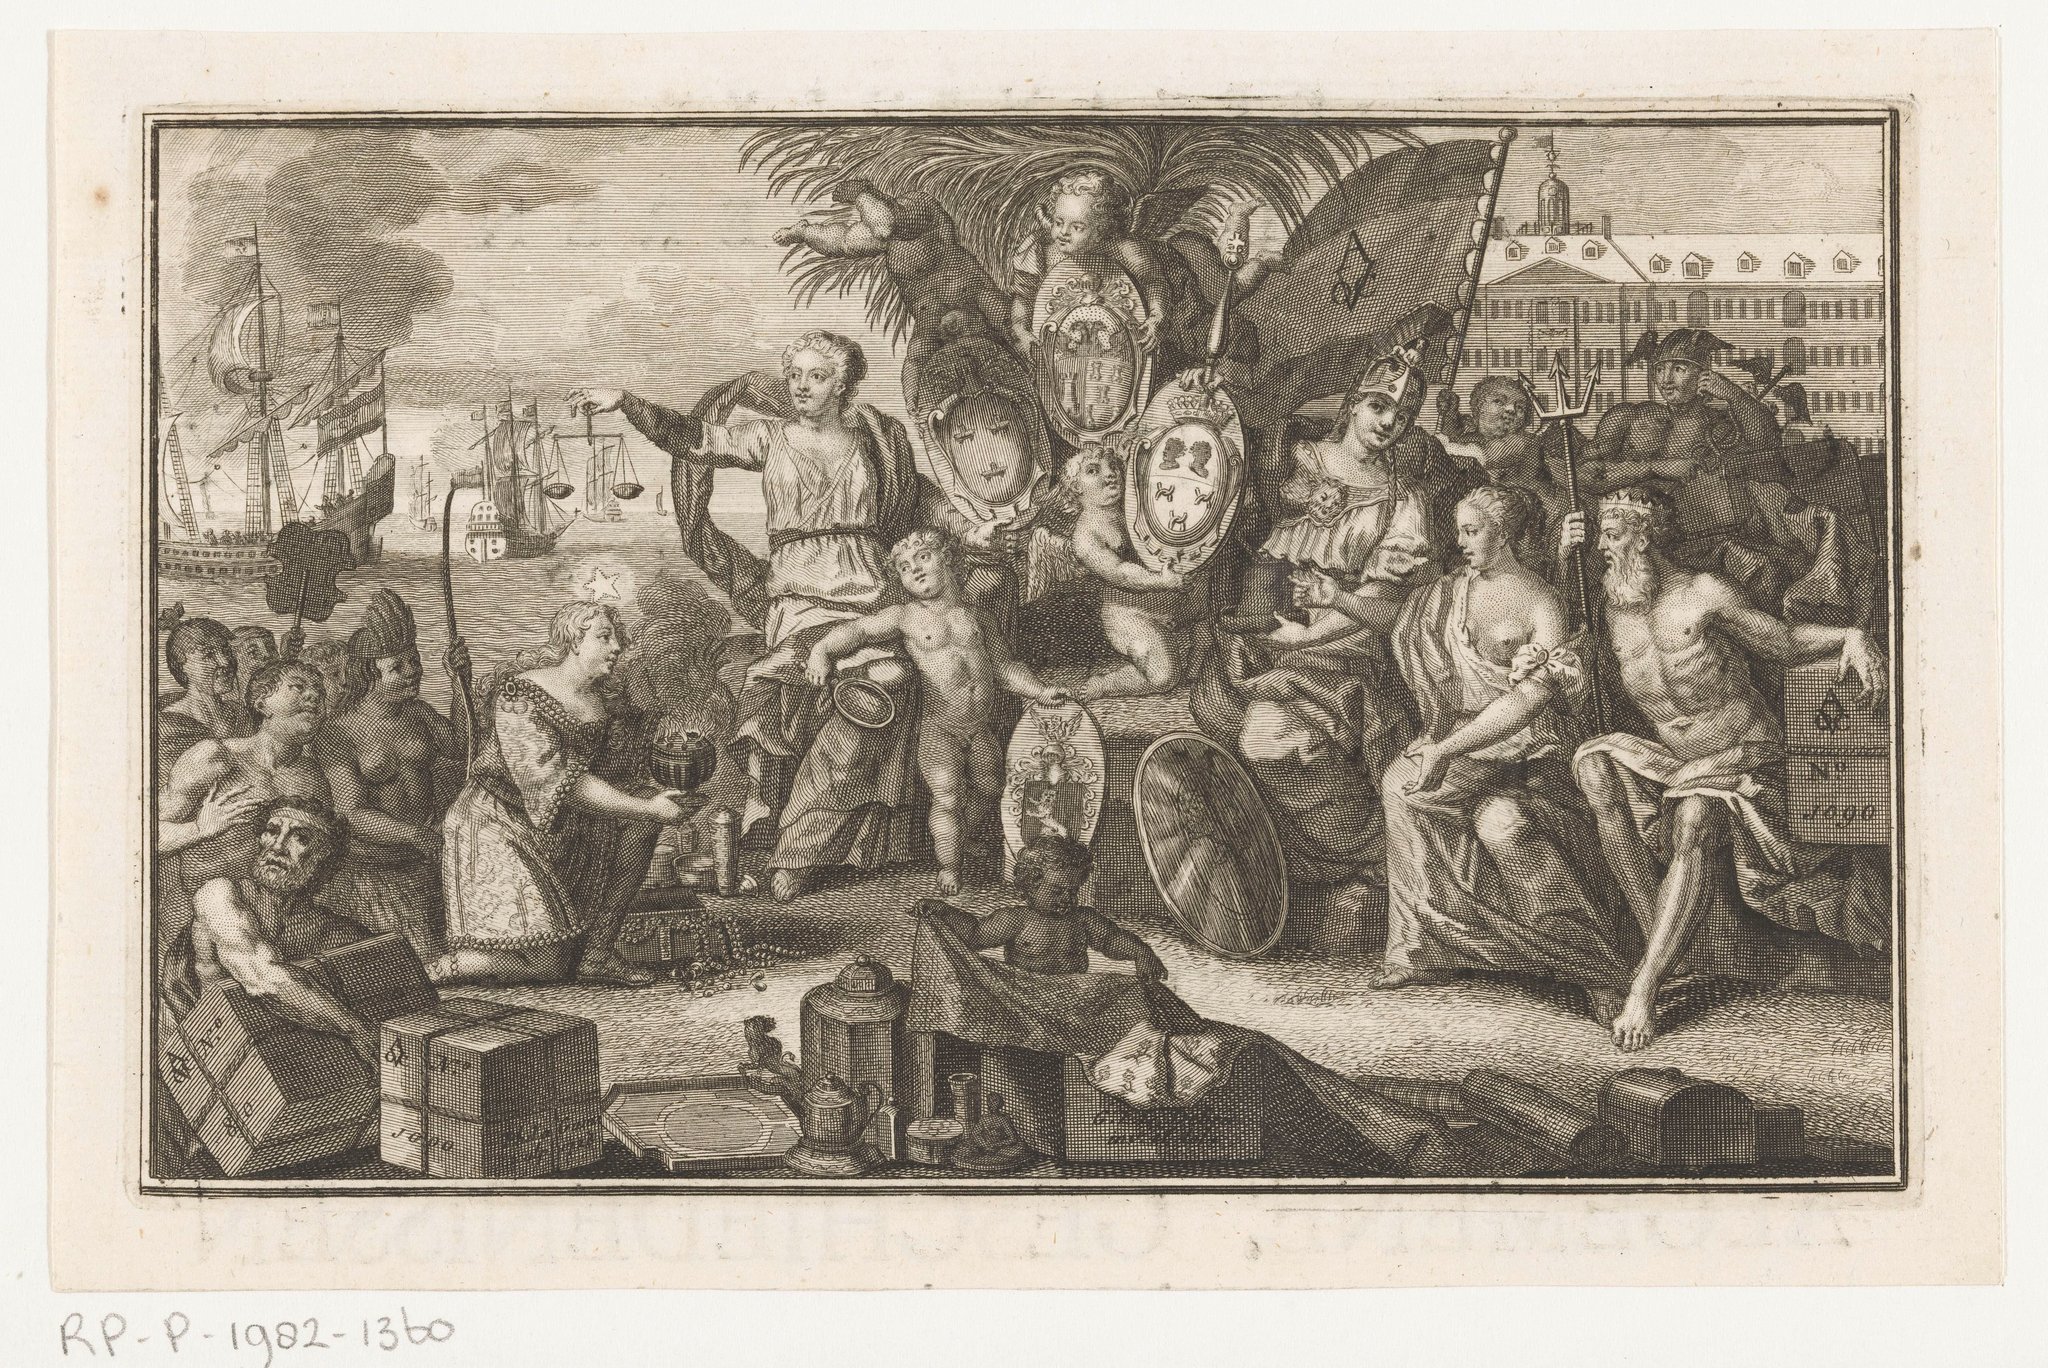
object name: print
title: Allegorie op de Oost-Indische Compagnie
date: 1728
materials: paper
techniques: etching, letterpress printing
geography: amsterdam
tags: asiatic races and peoples, trade-company, justice, 'justitia'; 'giustitia divina' (ripa) ~ one of the four cardinal virtues, (story of) minerva (pallas, athena)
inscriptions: collector's mark: Lugt 2760, collector's mark: Lugt 2228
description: Putti met wapenschilden van Aegidius van den Bempden, Hendrik Trip, Adriaan van Loon en Reinier Bouwens (burgemeester en bewindhebbers van de handelscompagnie) worden geflankeerd door Rechtvaardigheid met weegschaal en Minerva met (vrijheids)hoed in de hand. Rechts een putto met vlag van de VOC, Mercurius als handelsgod, Neptunus als god van de zee, een allegorische vrouwenfiguur en het Oostindisch-magazijn te Amsterdam. Links handelsschepen op zee, mensen die de Oost-Indische volkeren vertegenwoordigen en een vrouw met wierookvat en ster op het hoofd. Op de voorgrond handelswaar.